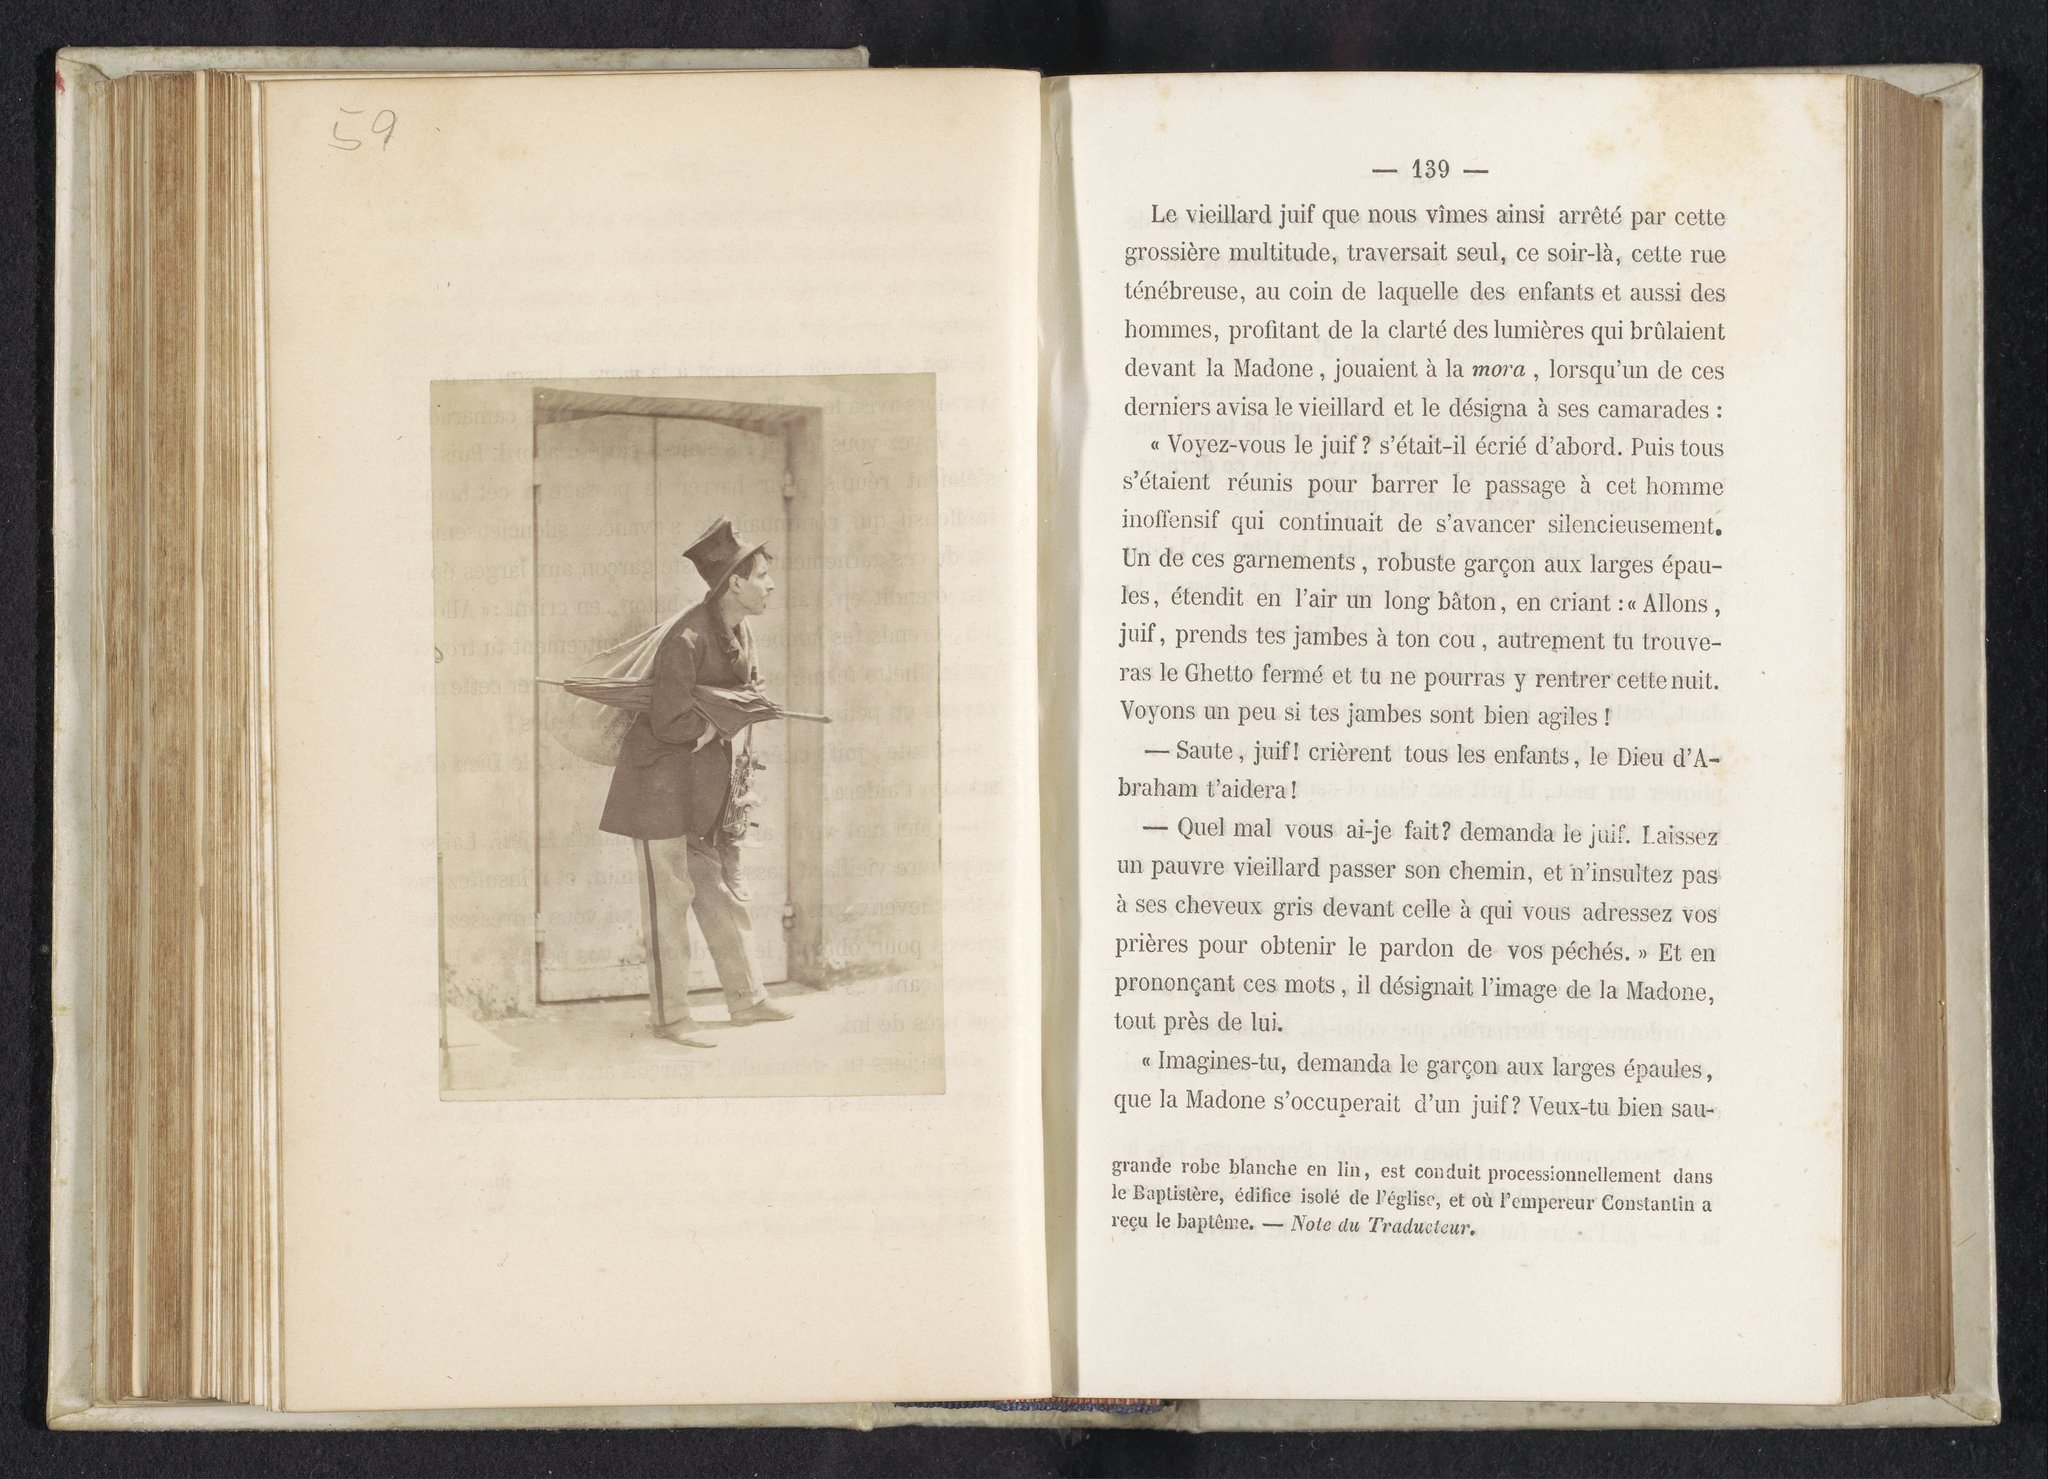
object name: photograph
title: Man met een paraplu en hoge hoed in een straat (vermoedelijk) te Rome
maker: Anonymous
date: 1850-1860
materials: photographic support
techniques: albumen print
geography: rome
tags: adult man, umbrella, head-gear: top hat